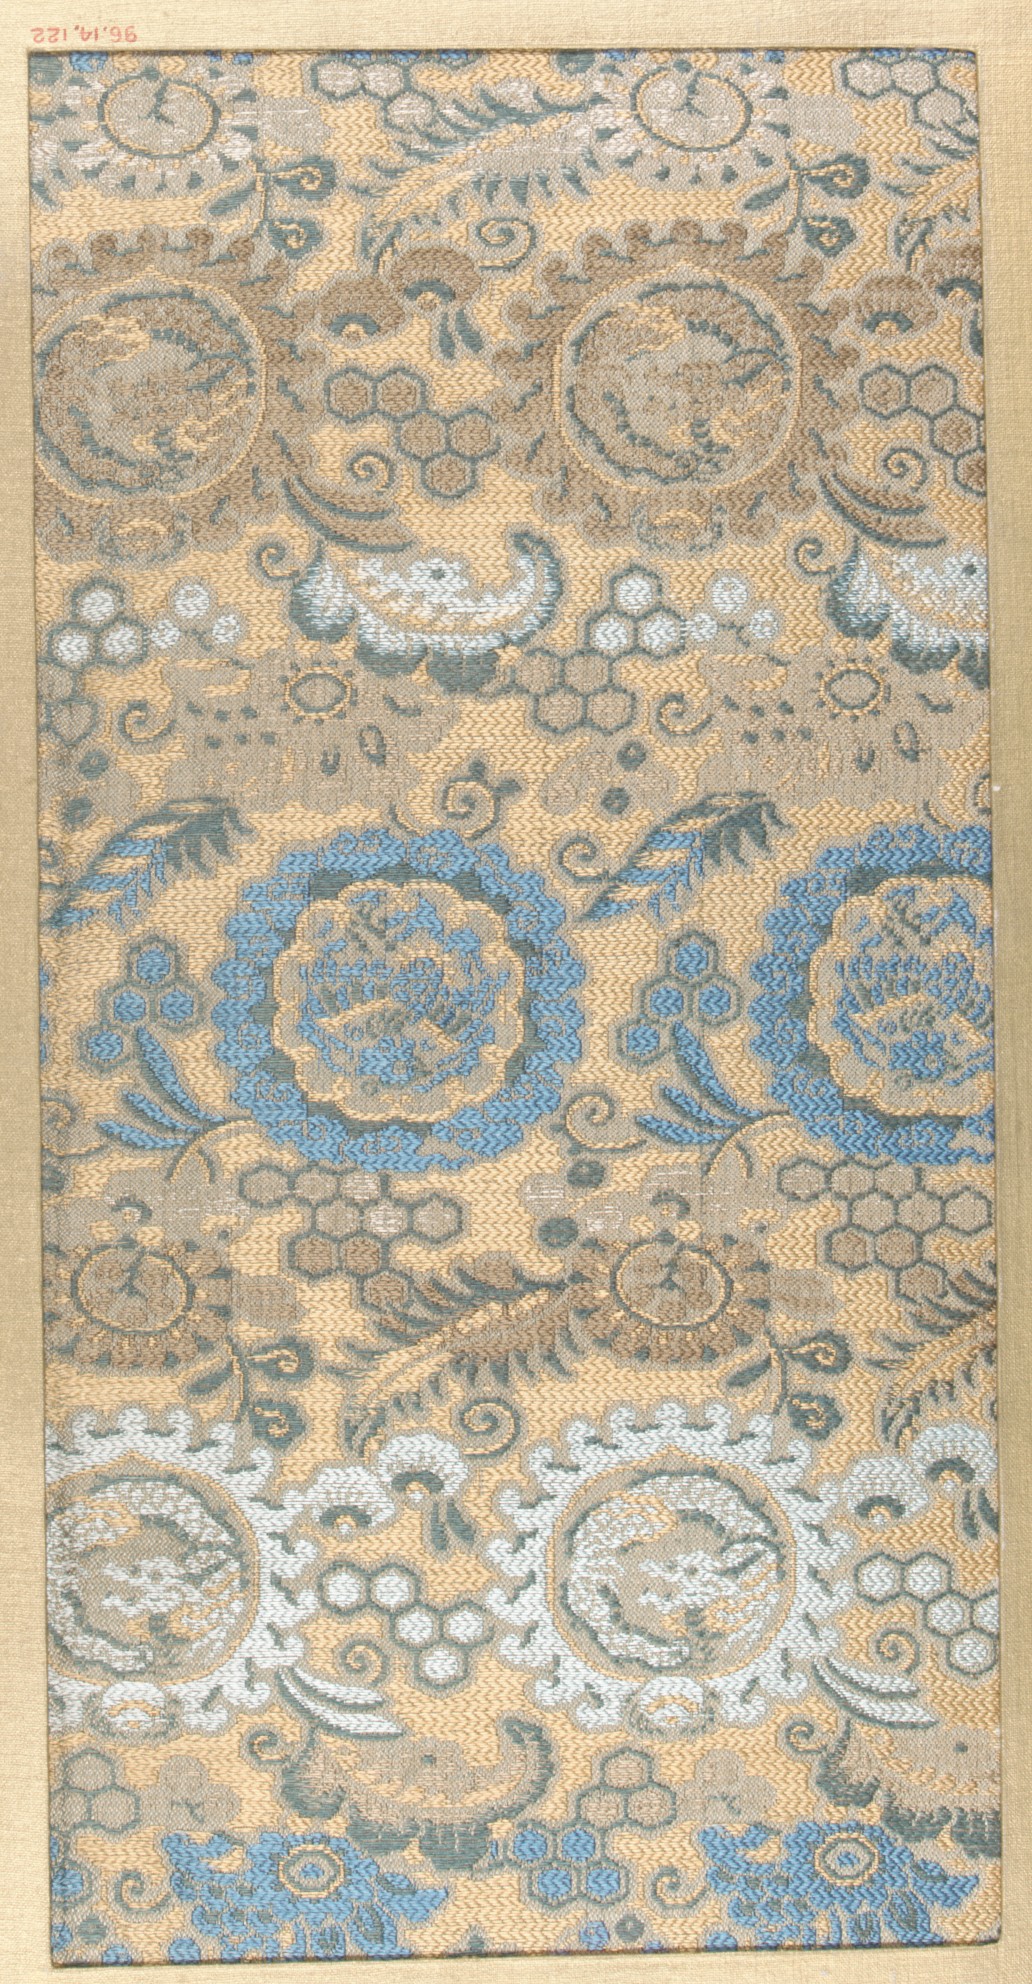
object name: piece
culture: japanese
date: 1701-1900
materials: silk